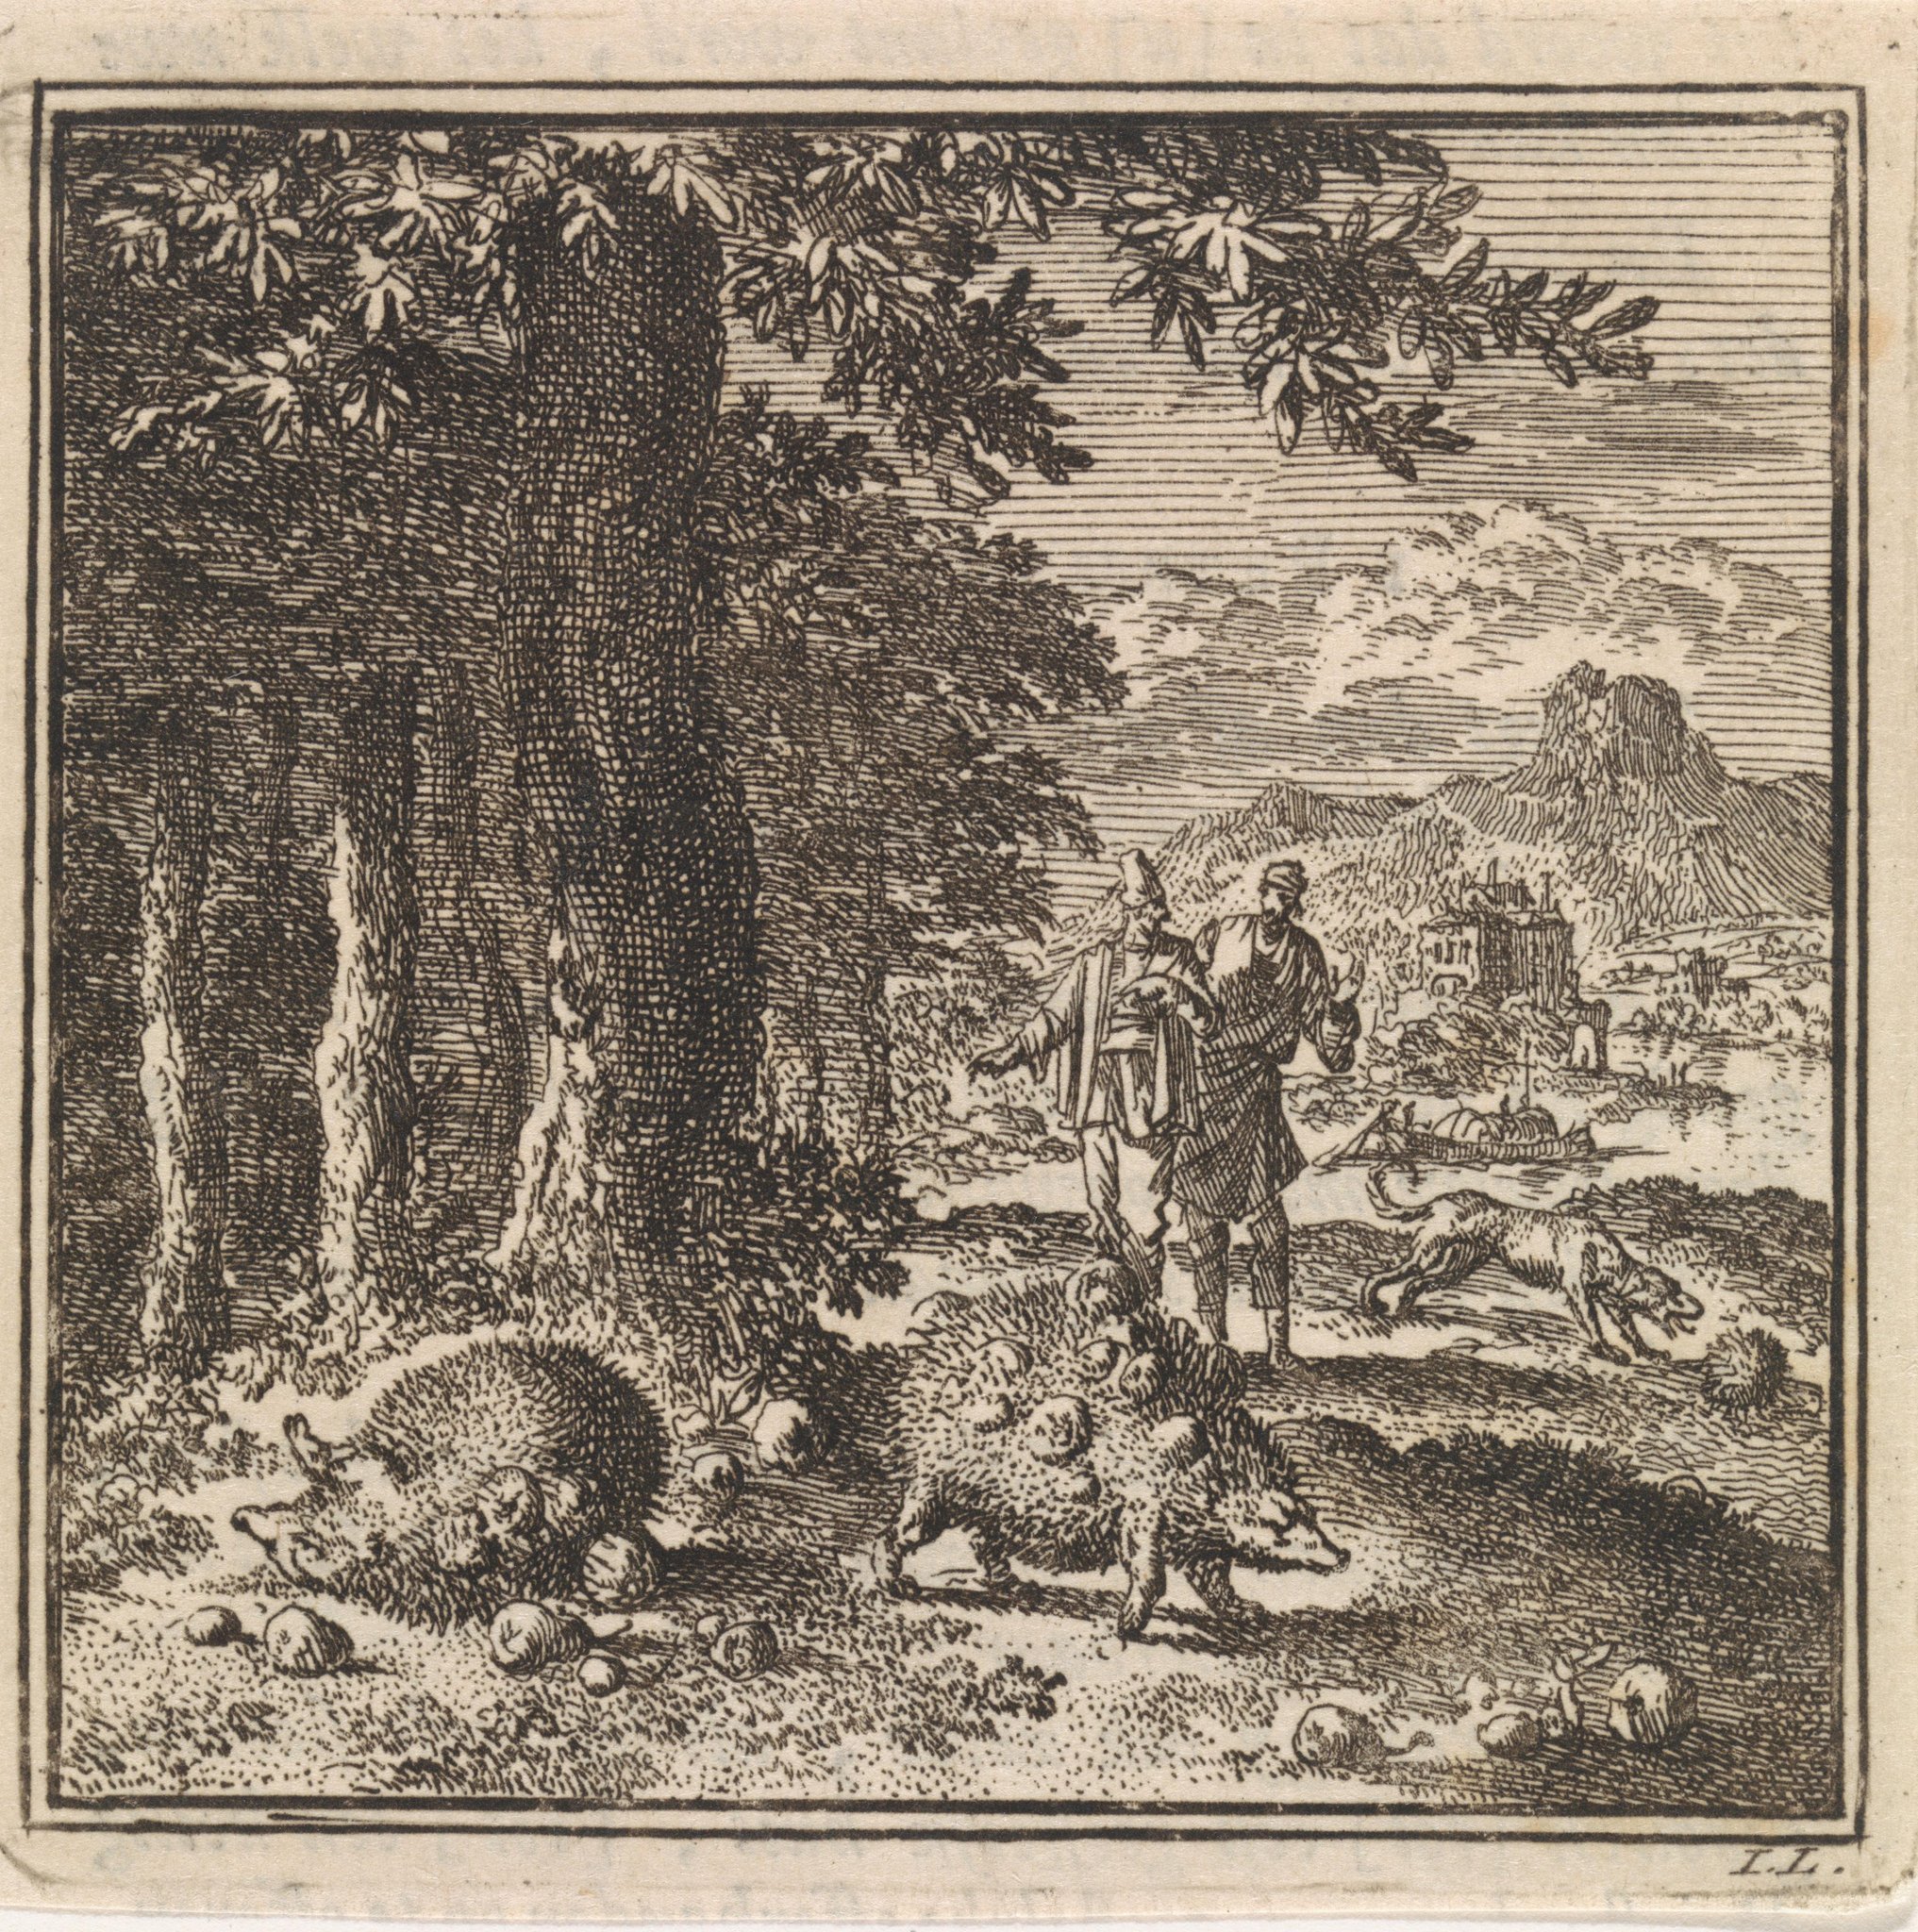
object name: book illustration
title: De Egel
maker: jan luyken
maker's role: draughtsman, print maker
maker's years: 1649-1712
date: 1711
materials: paper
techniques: etching, letterpress printing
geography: amsterdam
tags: forest, wood, other mammals: hedgehog, fruits, dog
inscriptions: collector's mark: Lugt 2228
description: Illustratie voor: Luyken, Jan. De Bykorf des Gemoeds. Amsterdam: Pieter Arentsz. II (wed.) en Cornelis van der Sys, 1711, p. 310.